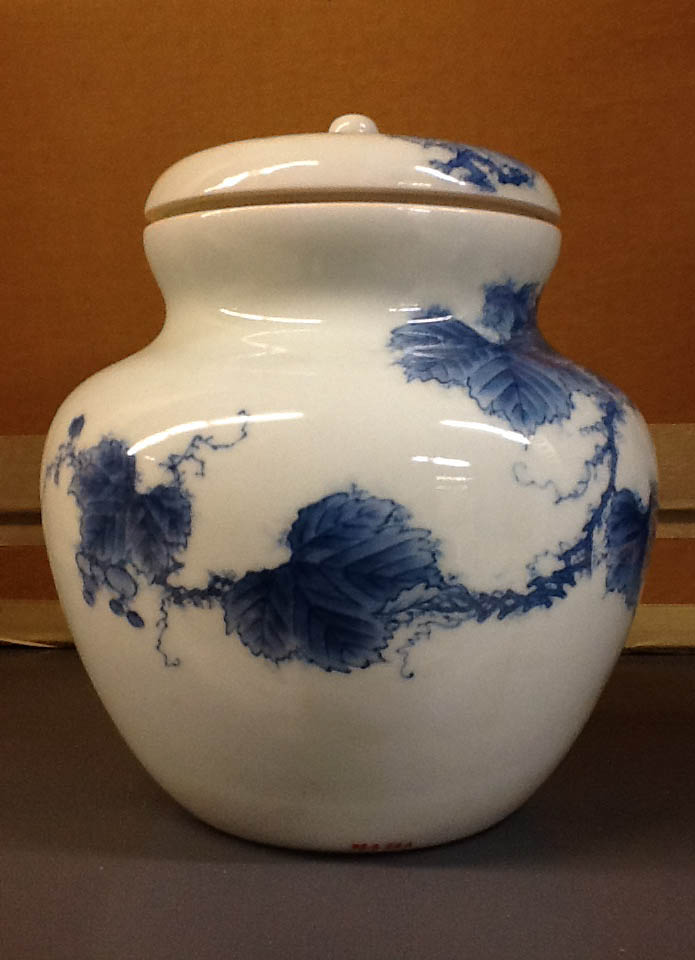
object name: jar with cover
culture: japanese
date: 1820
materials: glaze, porcelain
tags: leaves